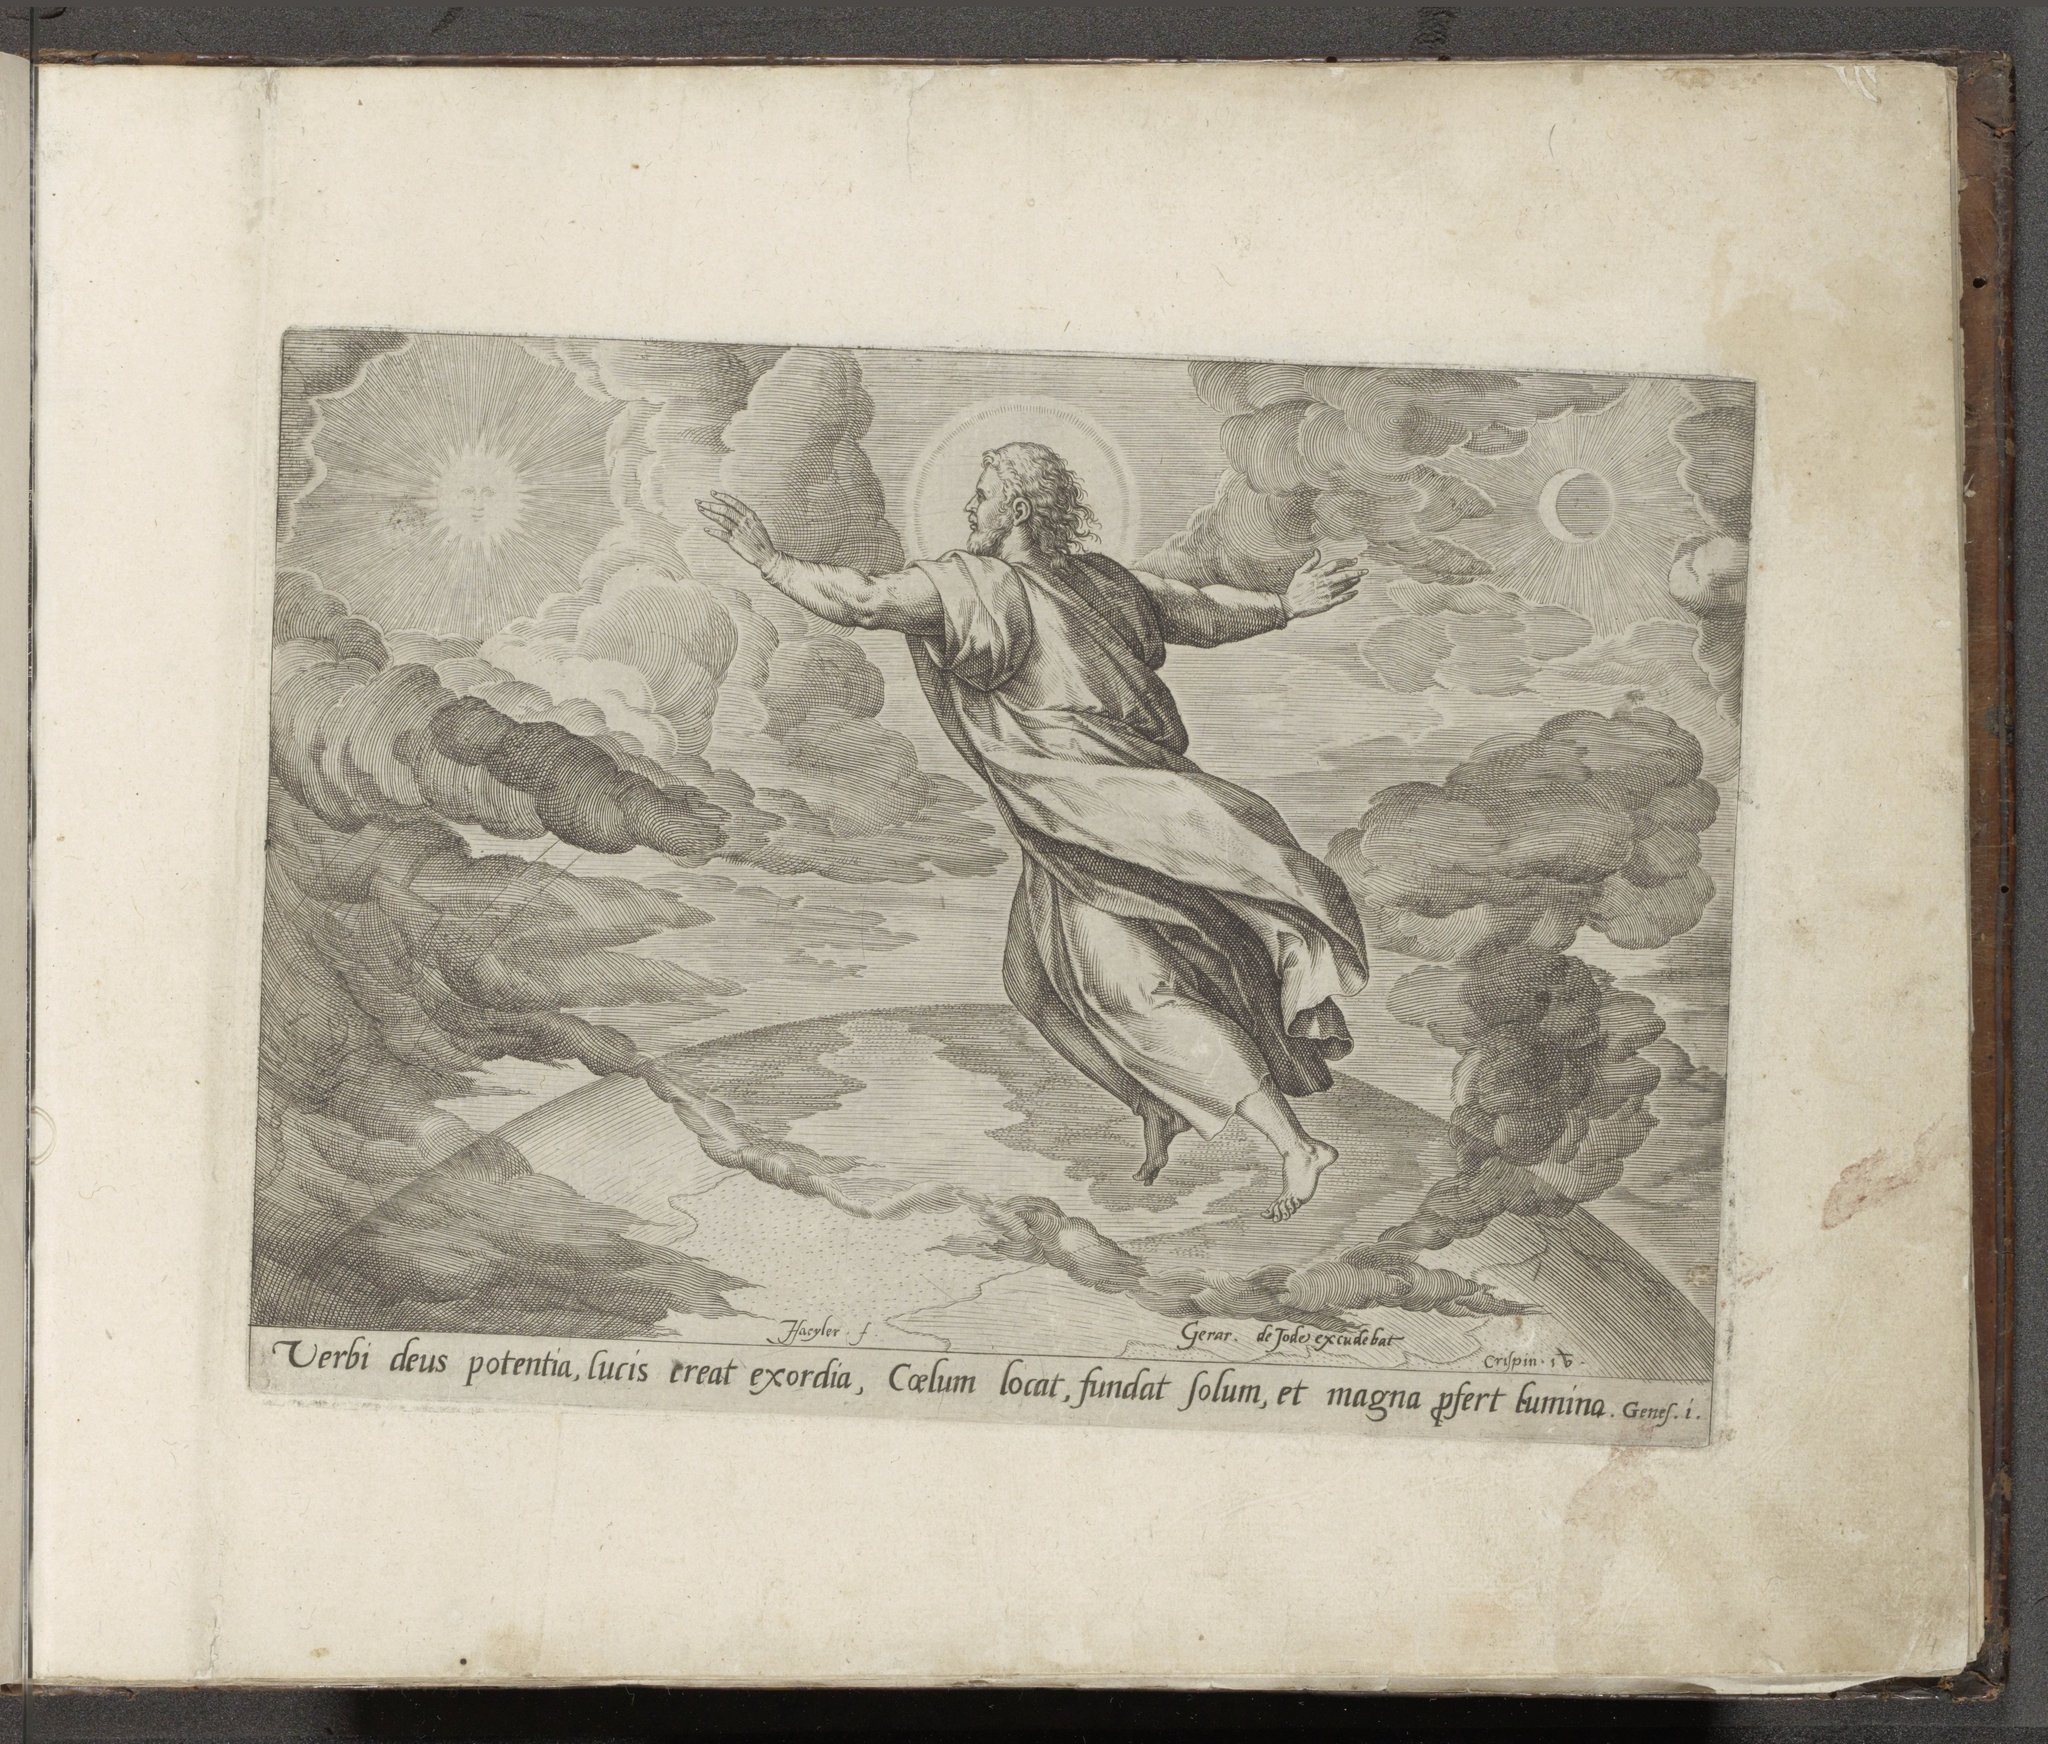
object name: album leaf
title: Thesaurus sacrarum historiaru[m] veteris testame[n]ti, elega[n]tissimis imaginibus expressu[m] excelle[n]tissimoru[m] in hac arte viroru[m] opera: nu[n]c primu[m] in luce[m] editus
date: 1579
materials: paper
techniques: engraving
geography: antwerp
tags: division of light and darkness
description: De eerste scheppingsdag: God de Vader zweeft boven de aarde met gestrekte armen en Hij scheidt het licht van het duister en dag van nacht. Links staat de zon en rechts de maan. Onderaan een verwijzing naar de Bijbeltekst in Gen. 1 in het Latijn. Prent maakt deel uit van een album.